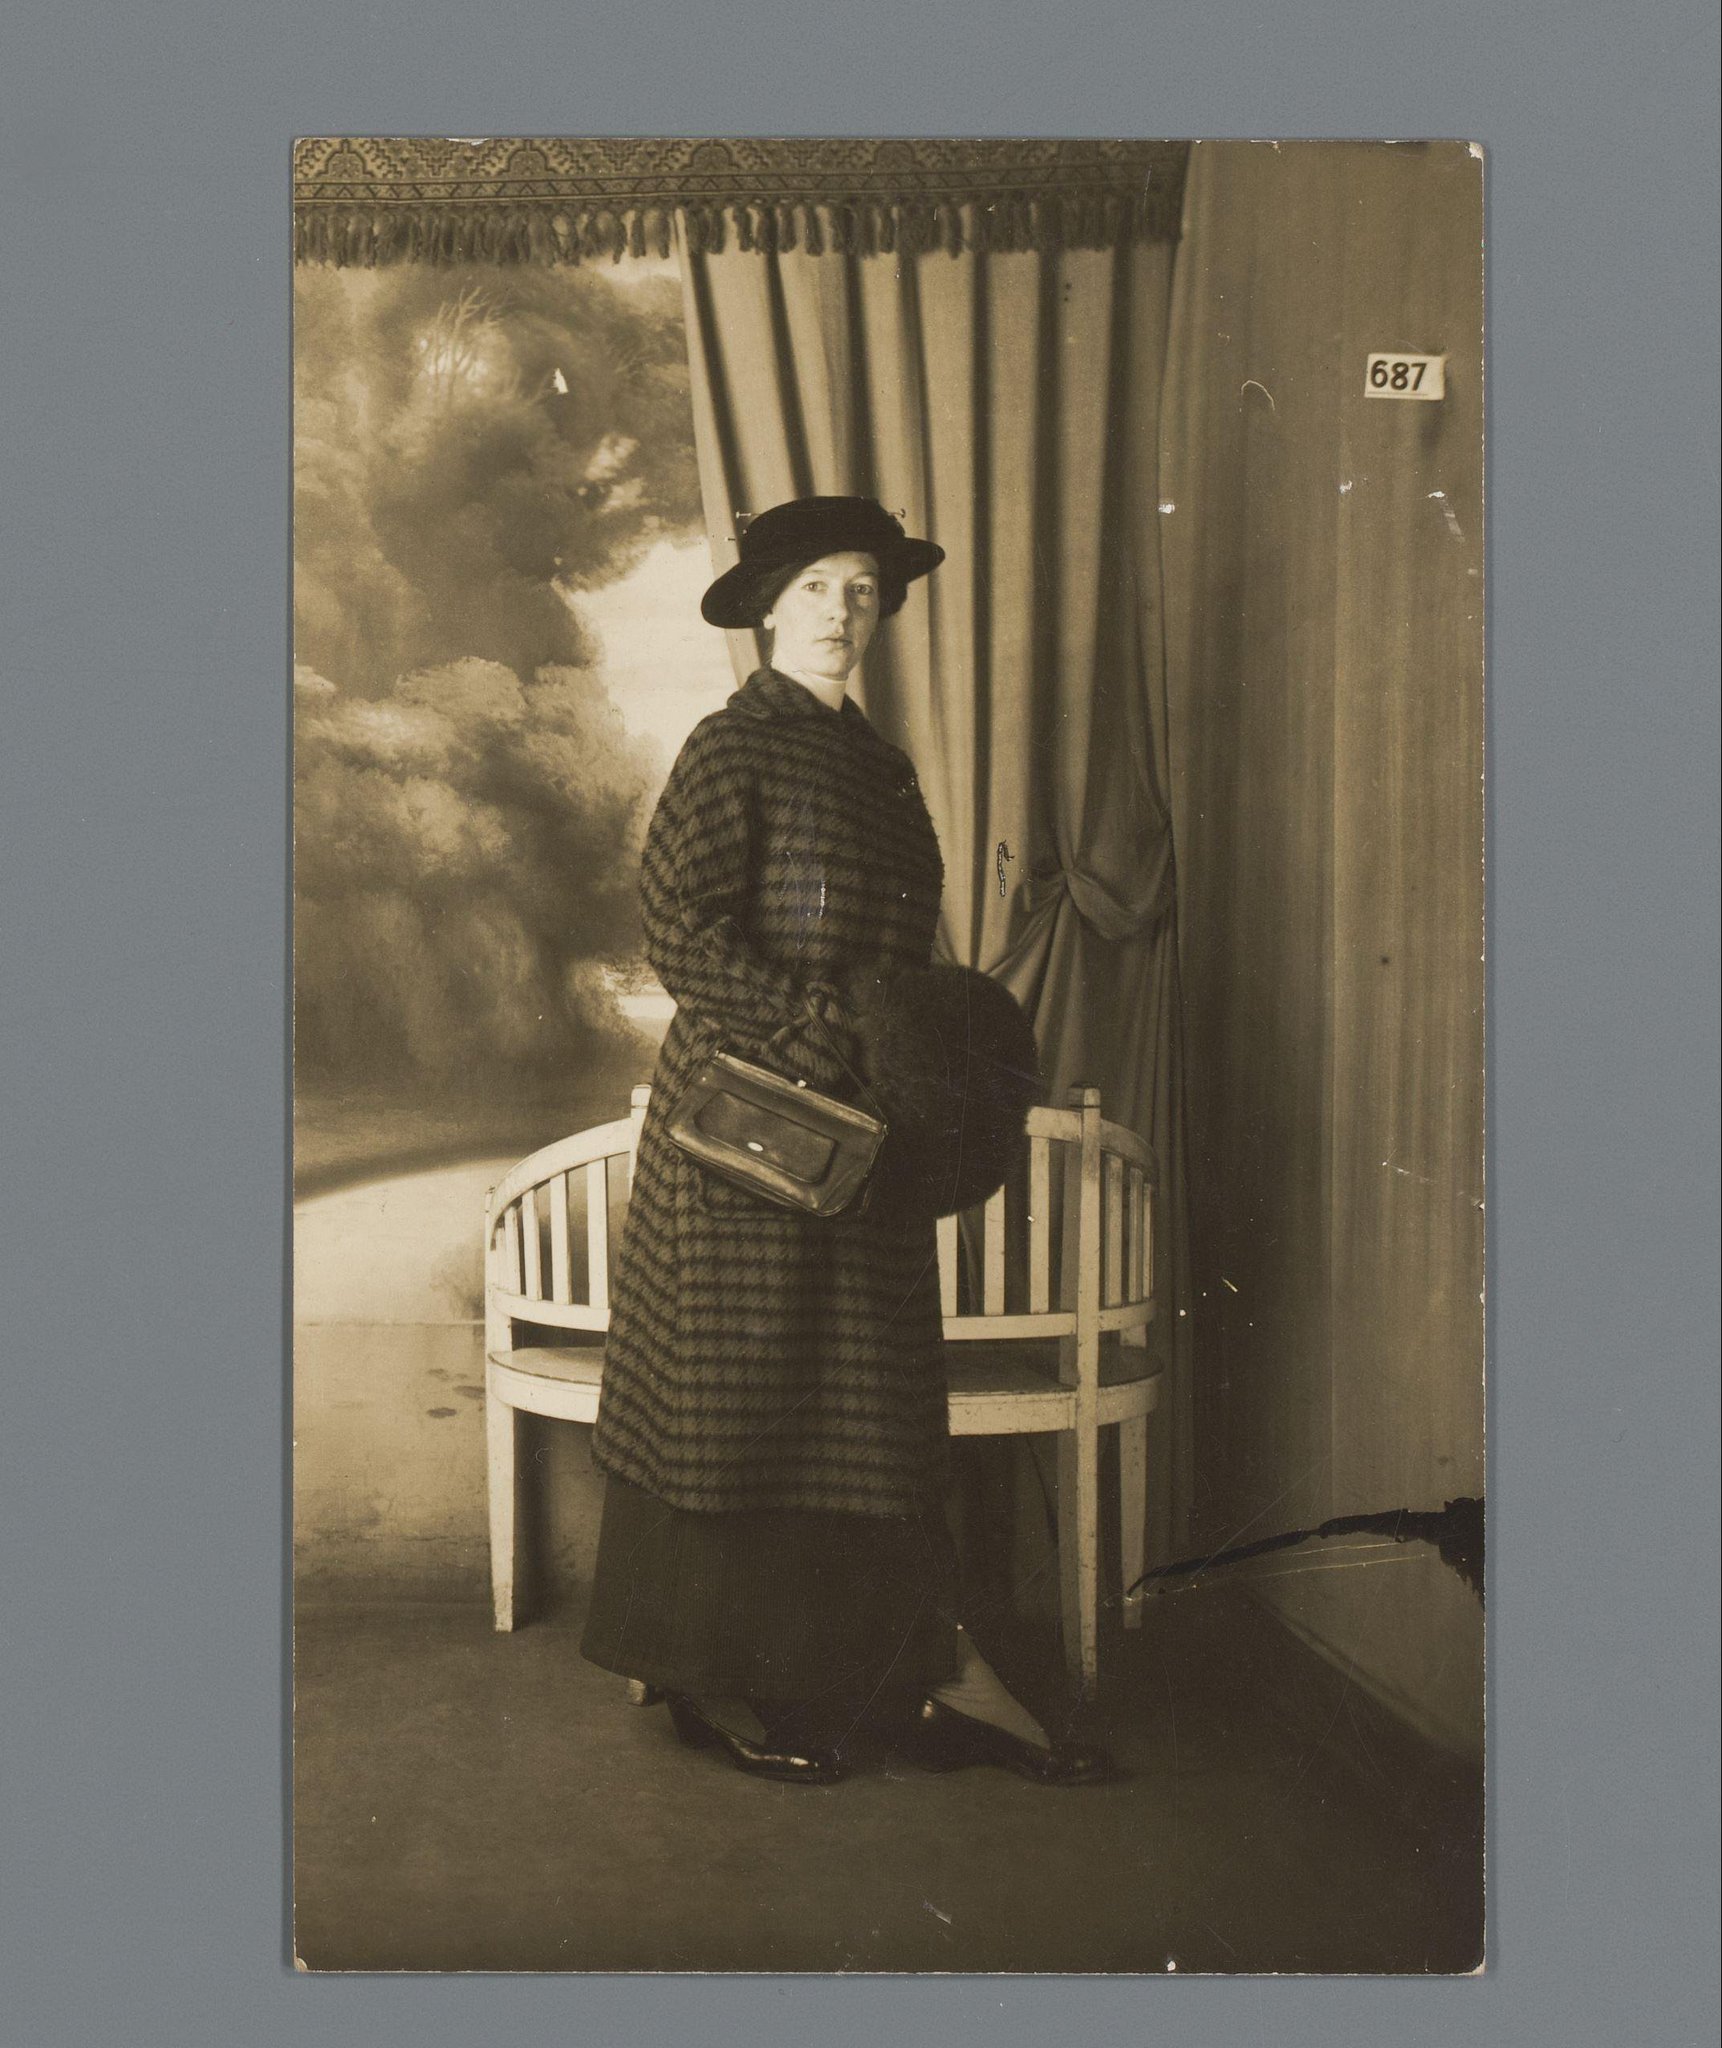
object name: snapshot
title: Portret van een onbekende vrouw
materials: paper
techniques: gelatin silver print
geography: amsterdam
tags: adult woman, anonymous historical person portrayed, amsterdam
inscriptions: inscription: ‘AMERICAN AUTOMATIC FOTOGRAFIE/ Kalverstraat 155.’